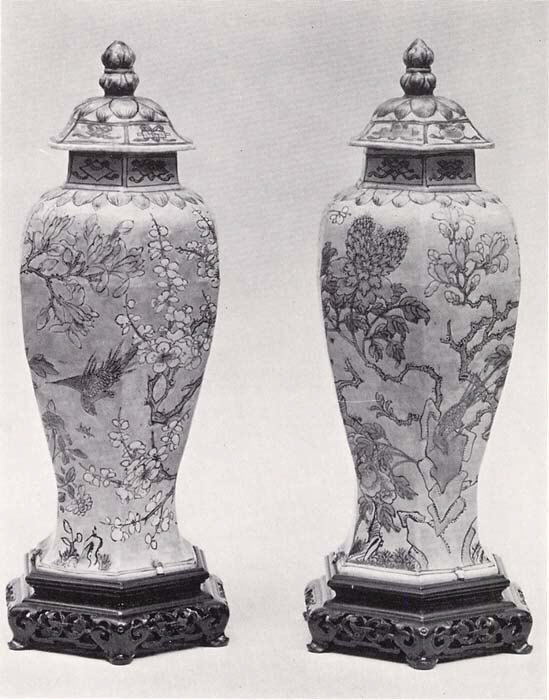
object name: vase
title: Vase (one of a pair)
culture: chinese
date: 1667-1733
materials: biscuit, enamel, porcelain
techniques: painting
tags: birds,flowers,leaves